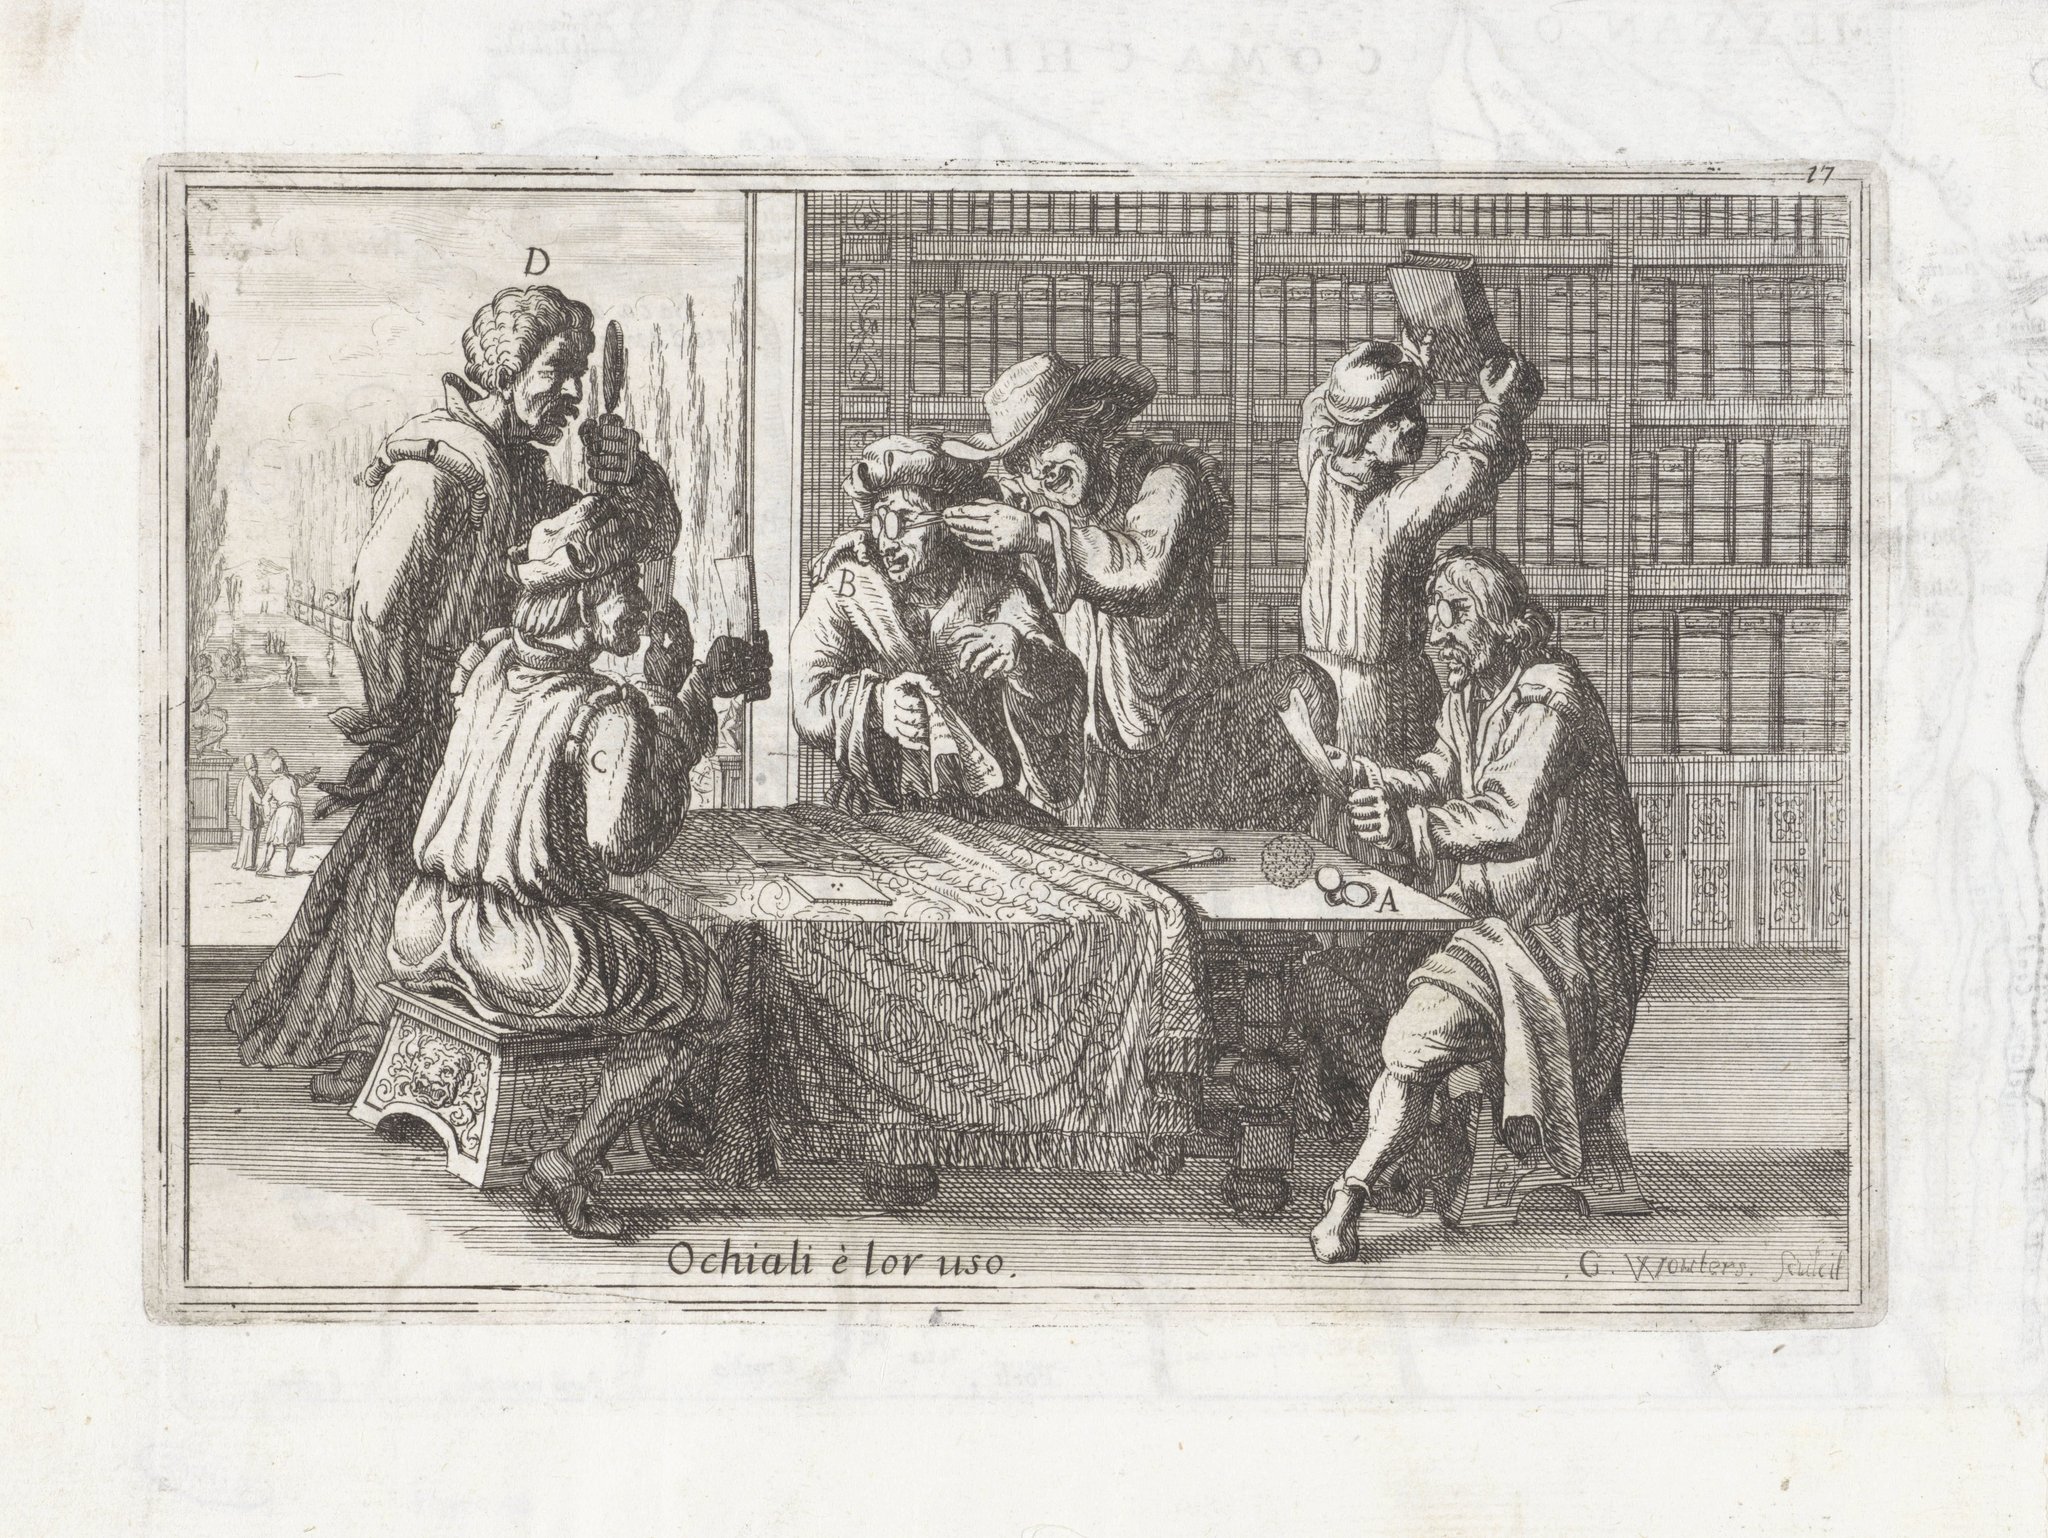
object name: book illustration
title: Het gebruik van brillen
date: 1696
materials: paper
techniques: etching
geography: rome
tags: eyeglasses, spectacles, book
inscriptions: collector's mark: Lugt 2228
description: Boekillustratie voor: Meyer, Cornelis. L'arte di rendere i fiumi navigabili in varii modi, con altre nuova inuentioni, e varij segreti : Divisa in tre parti : con tre Tauole in lingua Latina, Francese, e Ollandese. 3 dln. Roma : Gio Giac. Komarek Boëmo, 1696.